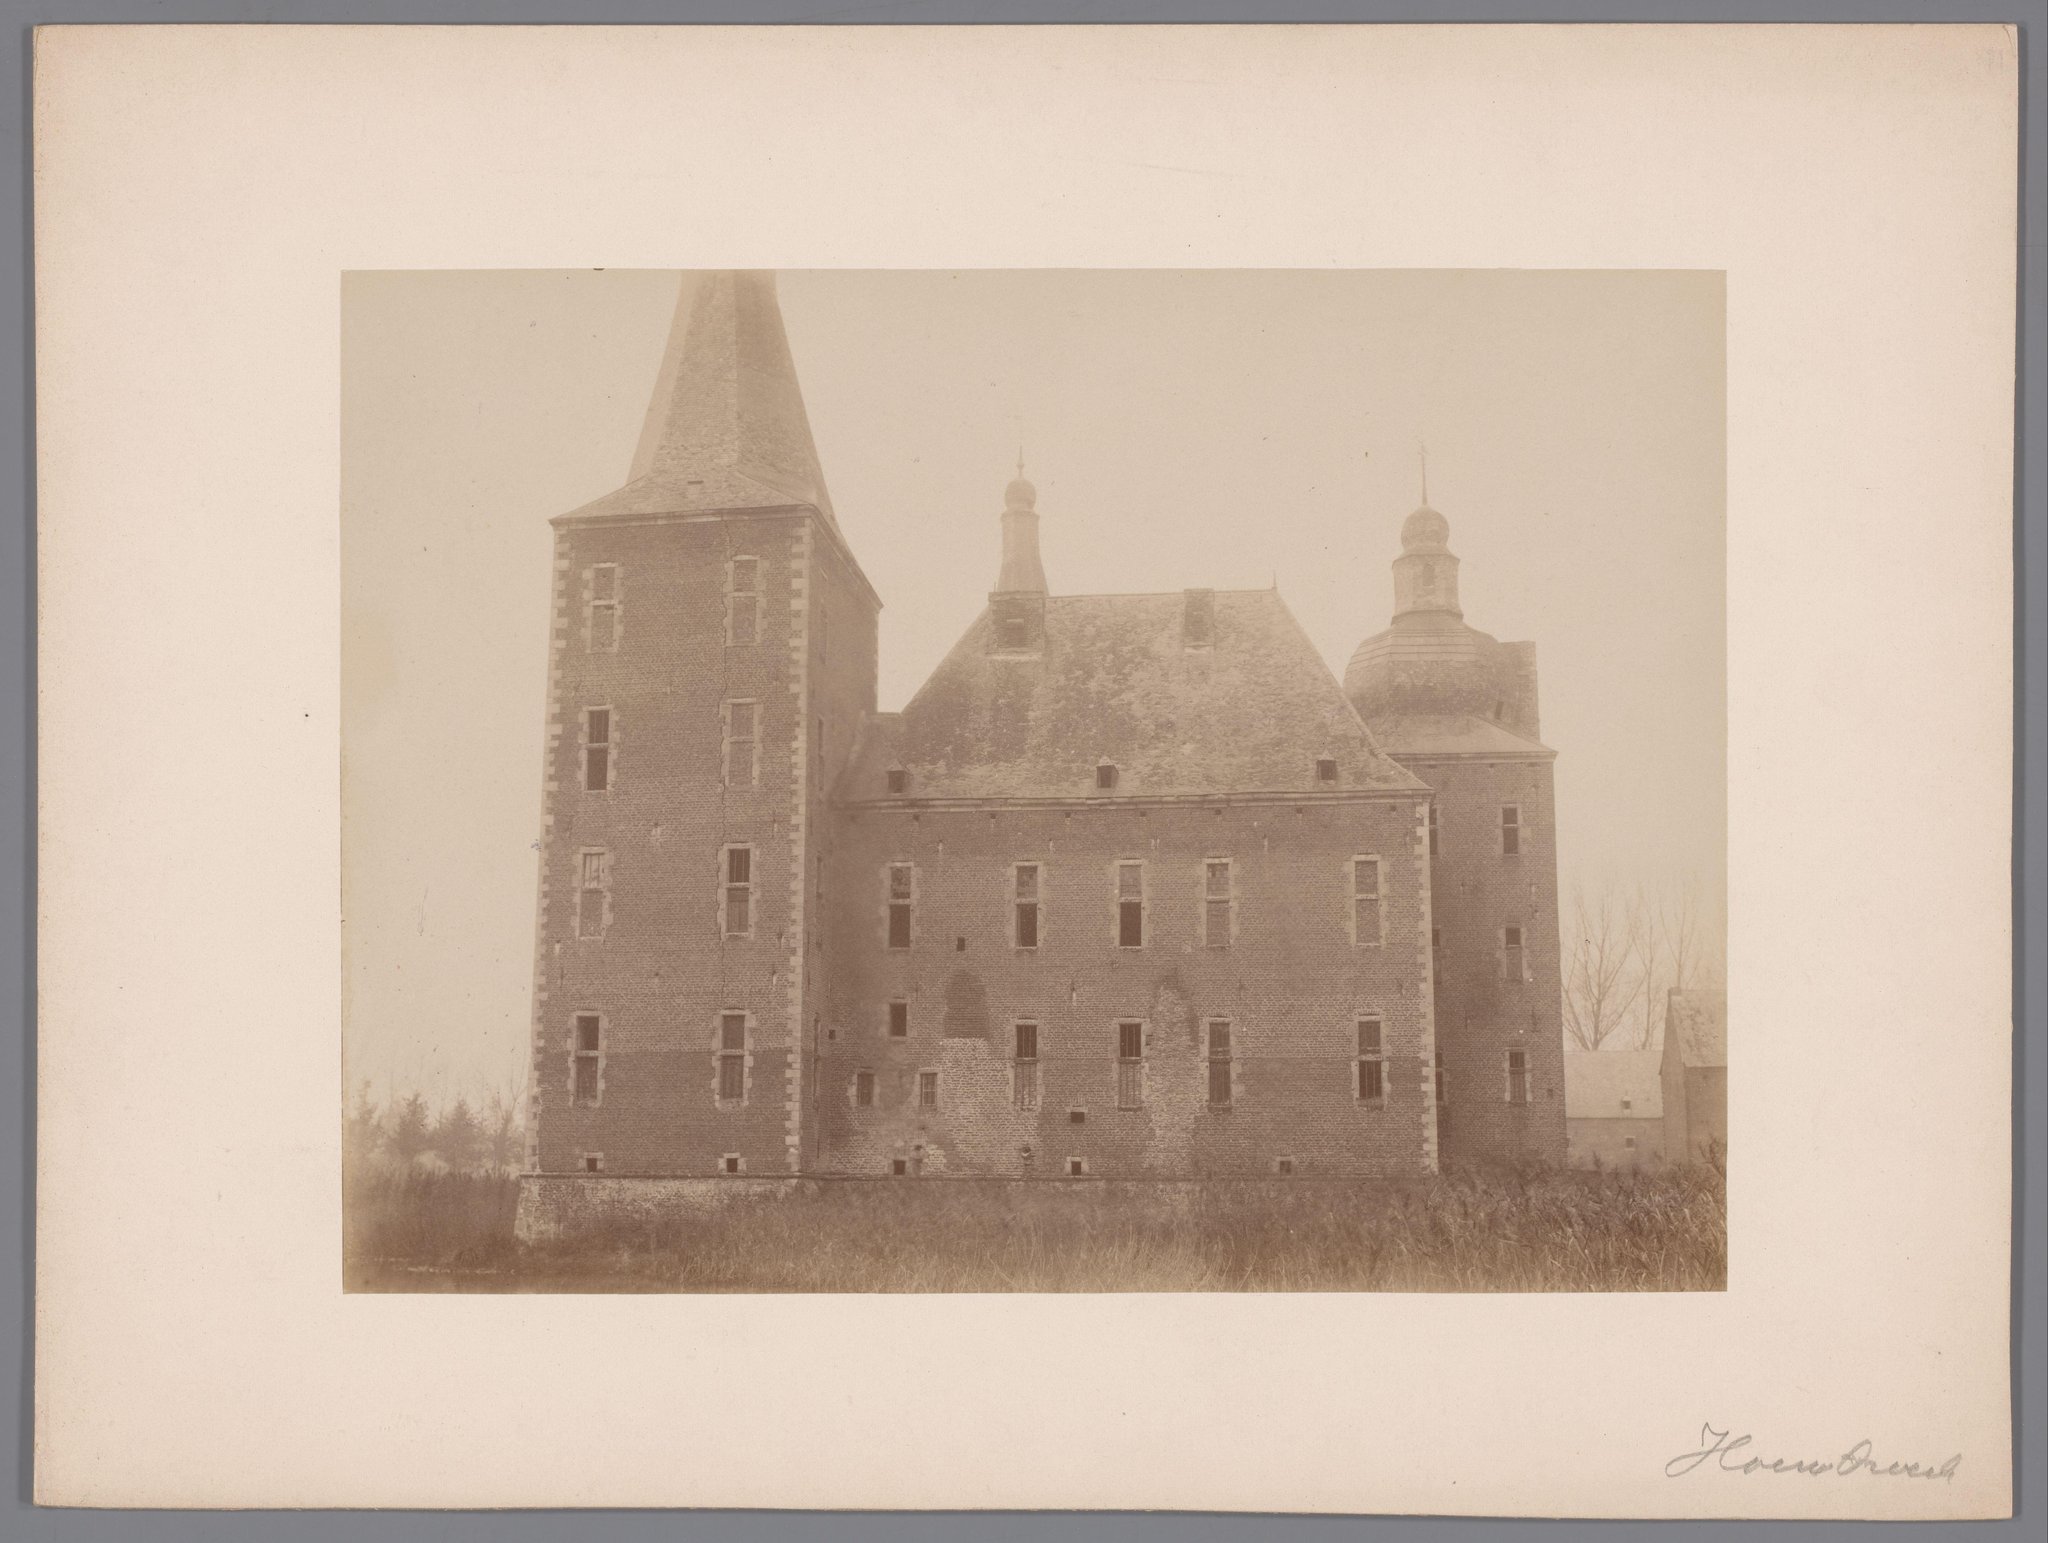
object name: photograph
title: Zuidoostzijde van Kasteel Hoensbroek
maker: anoniem (monumentenzorg)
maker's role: fotograaf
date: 1903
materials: cardboard, photographic support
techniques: albumen print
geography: hoensbroek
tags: castle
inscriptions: annotation: ‘Hoensbroek’, annotation: ‘Hoensbroek/ kasteel/ nov 1903’